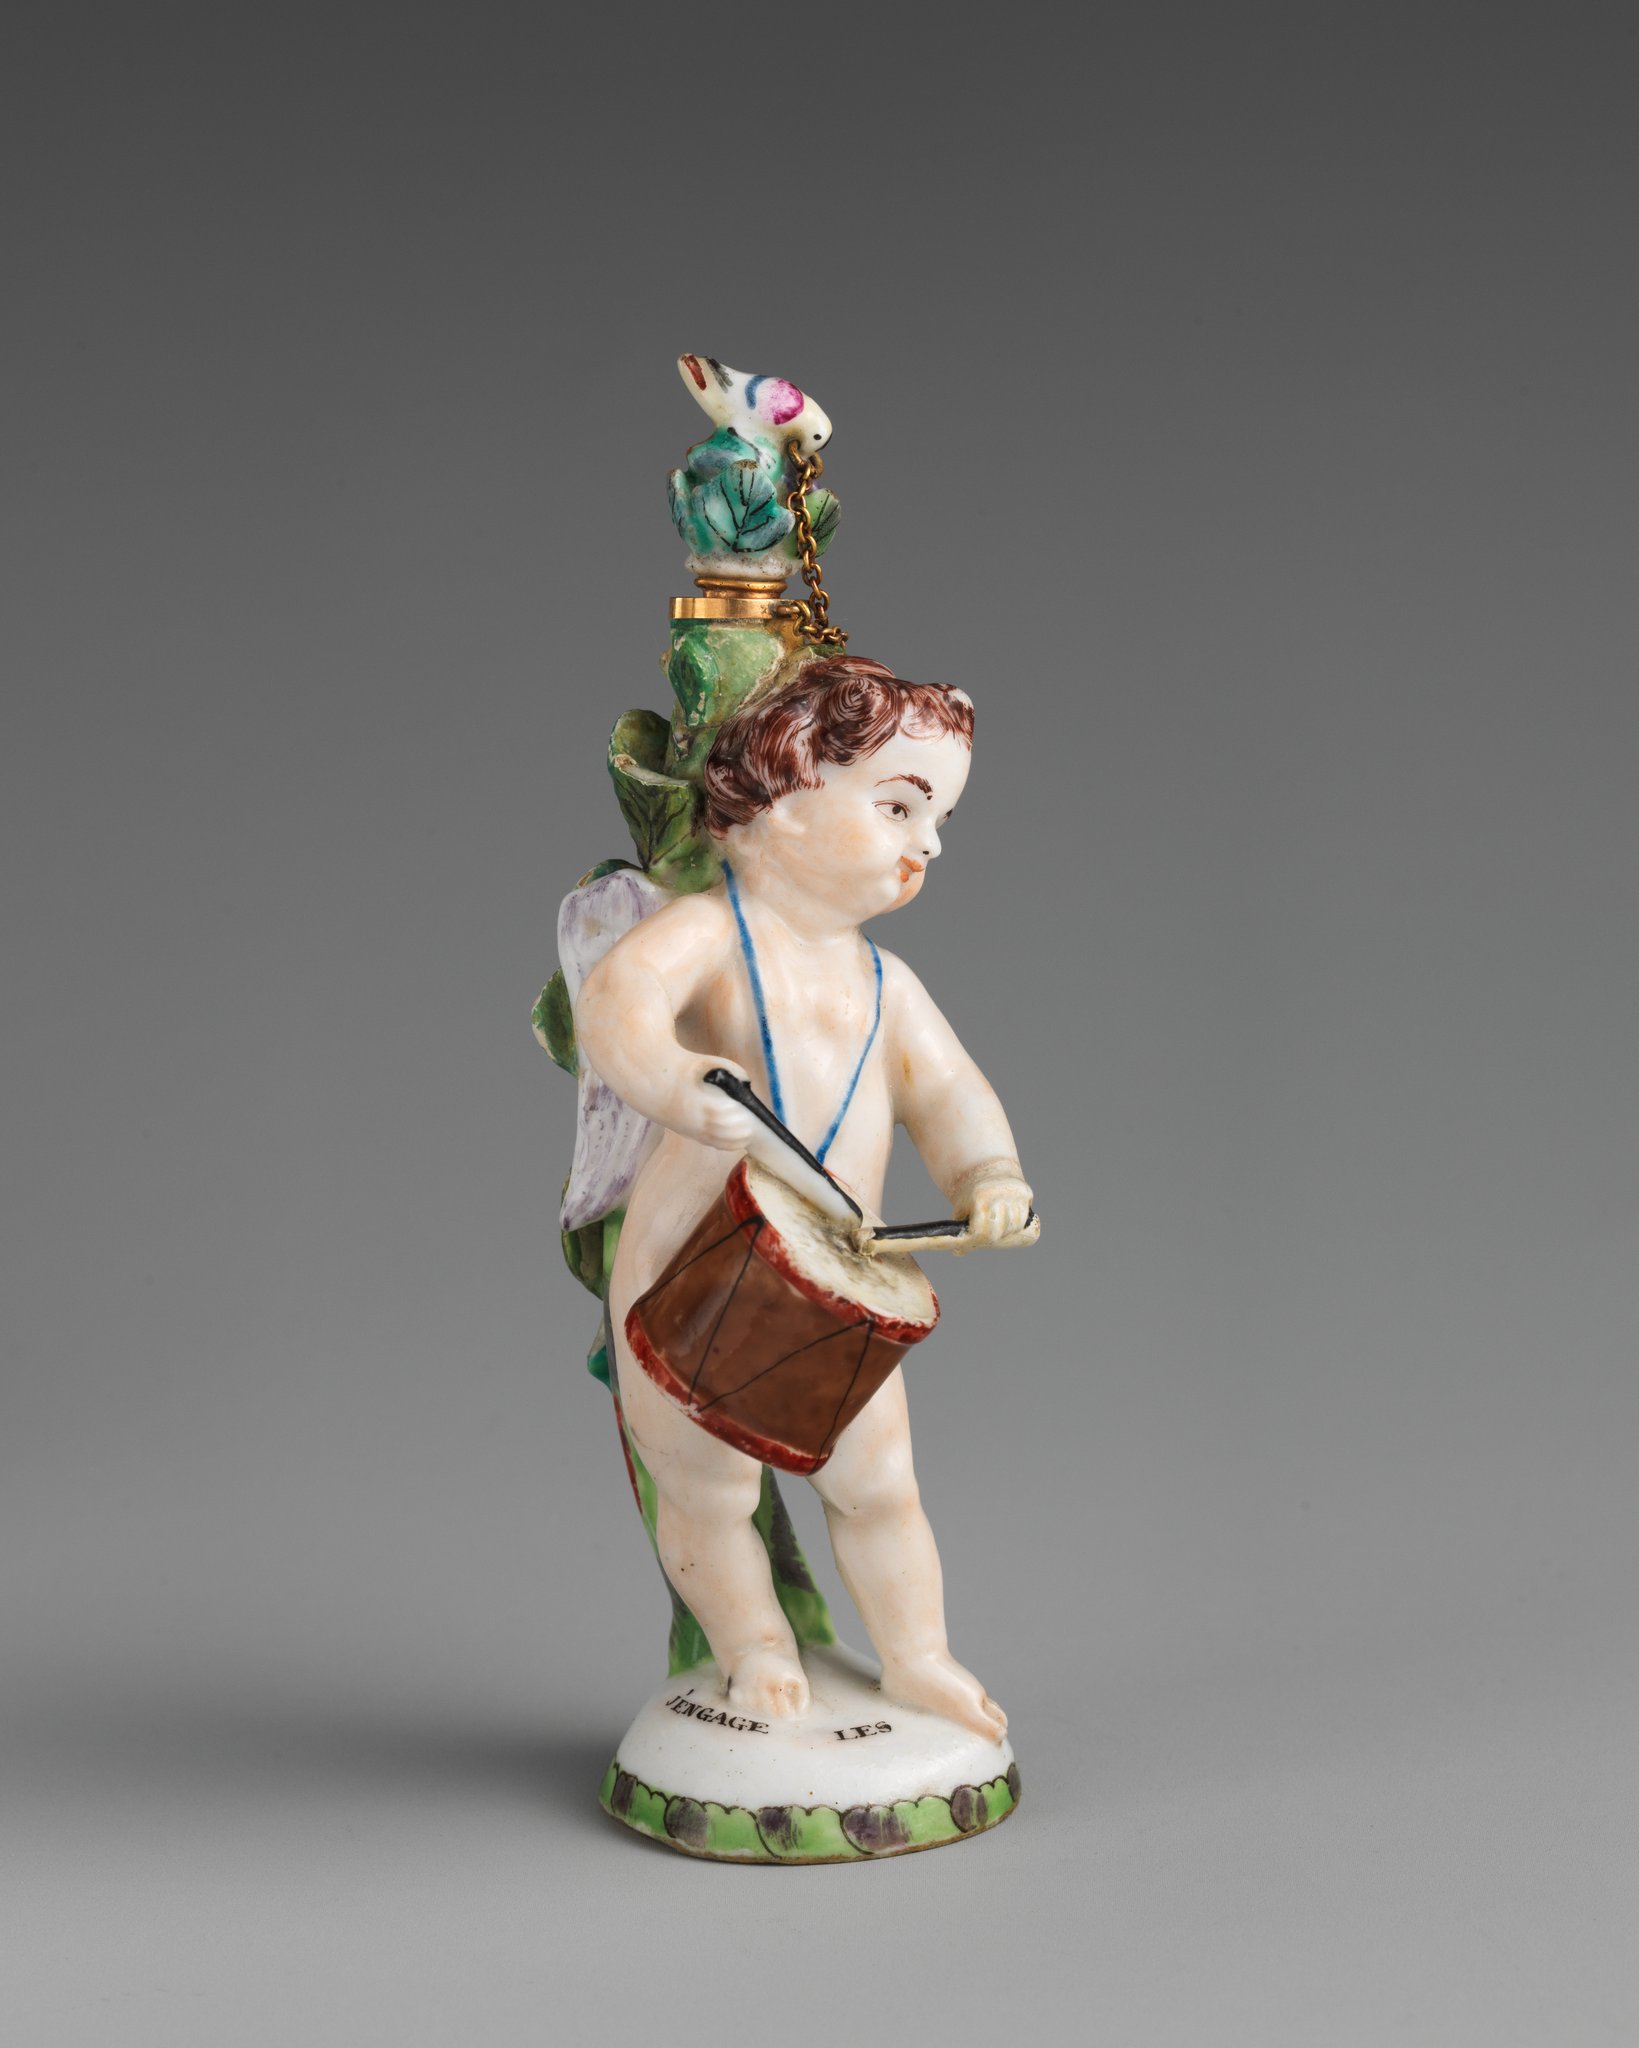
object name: scent bottle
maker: saint james's factory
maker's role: maker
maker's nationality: british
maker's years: 1749-1759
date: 1750-1755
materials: soft paste porcelain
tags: birds,drums,cupid